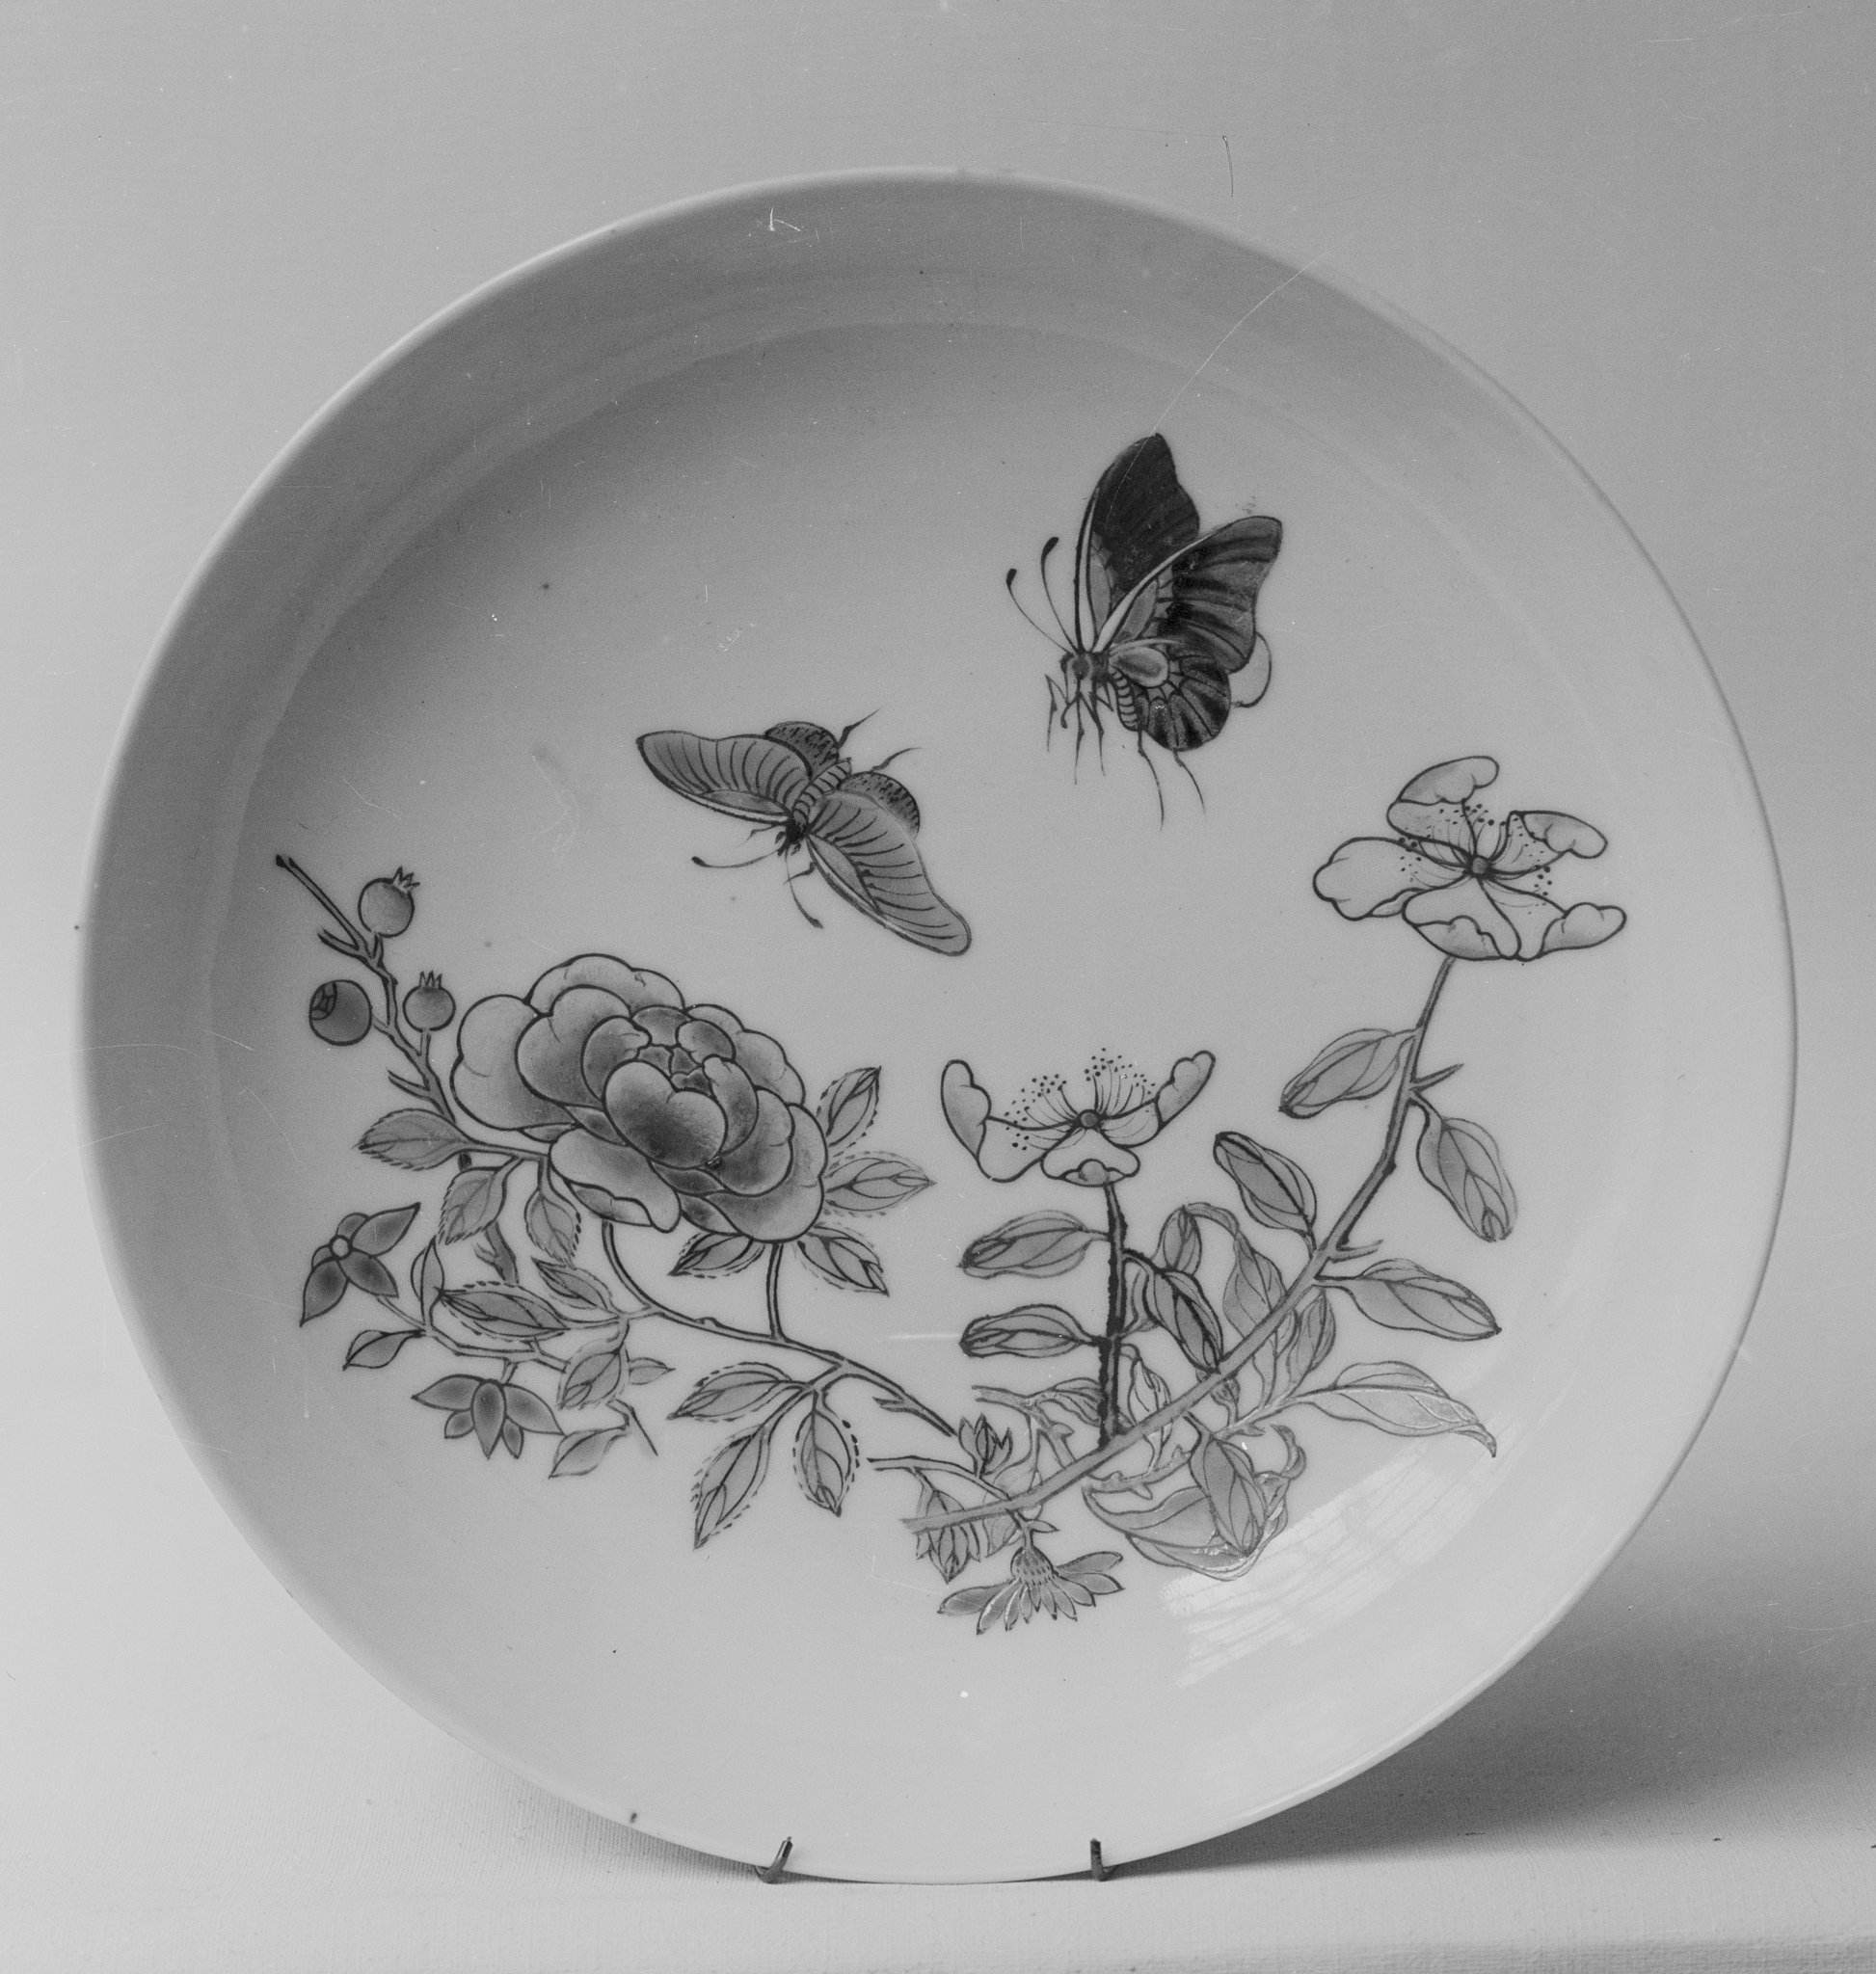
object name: saucer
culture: chinese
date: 1801-1850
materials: enamel, glaze, porcelain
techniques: overglaze, painting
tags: butterflies,flowers